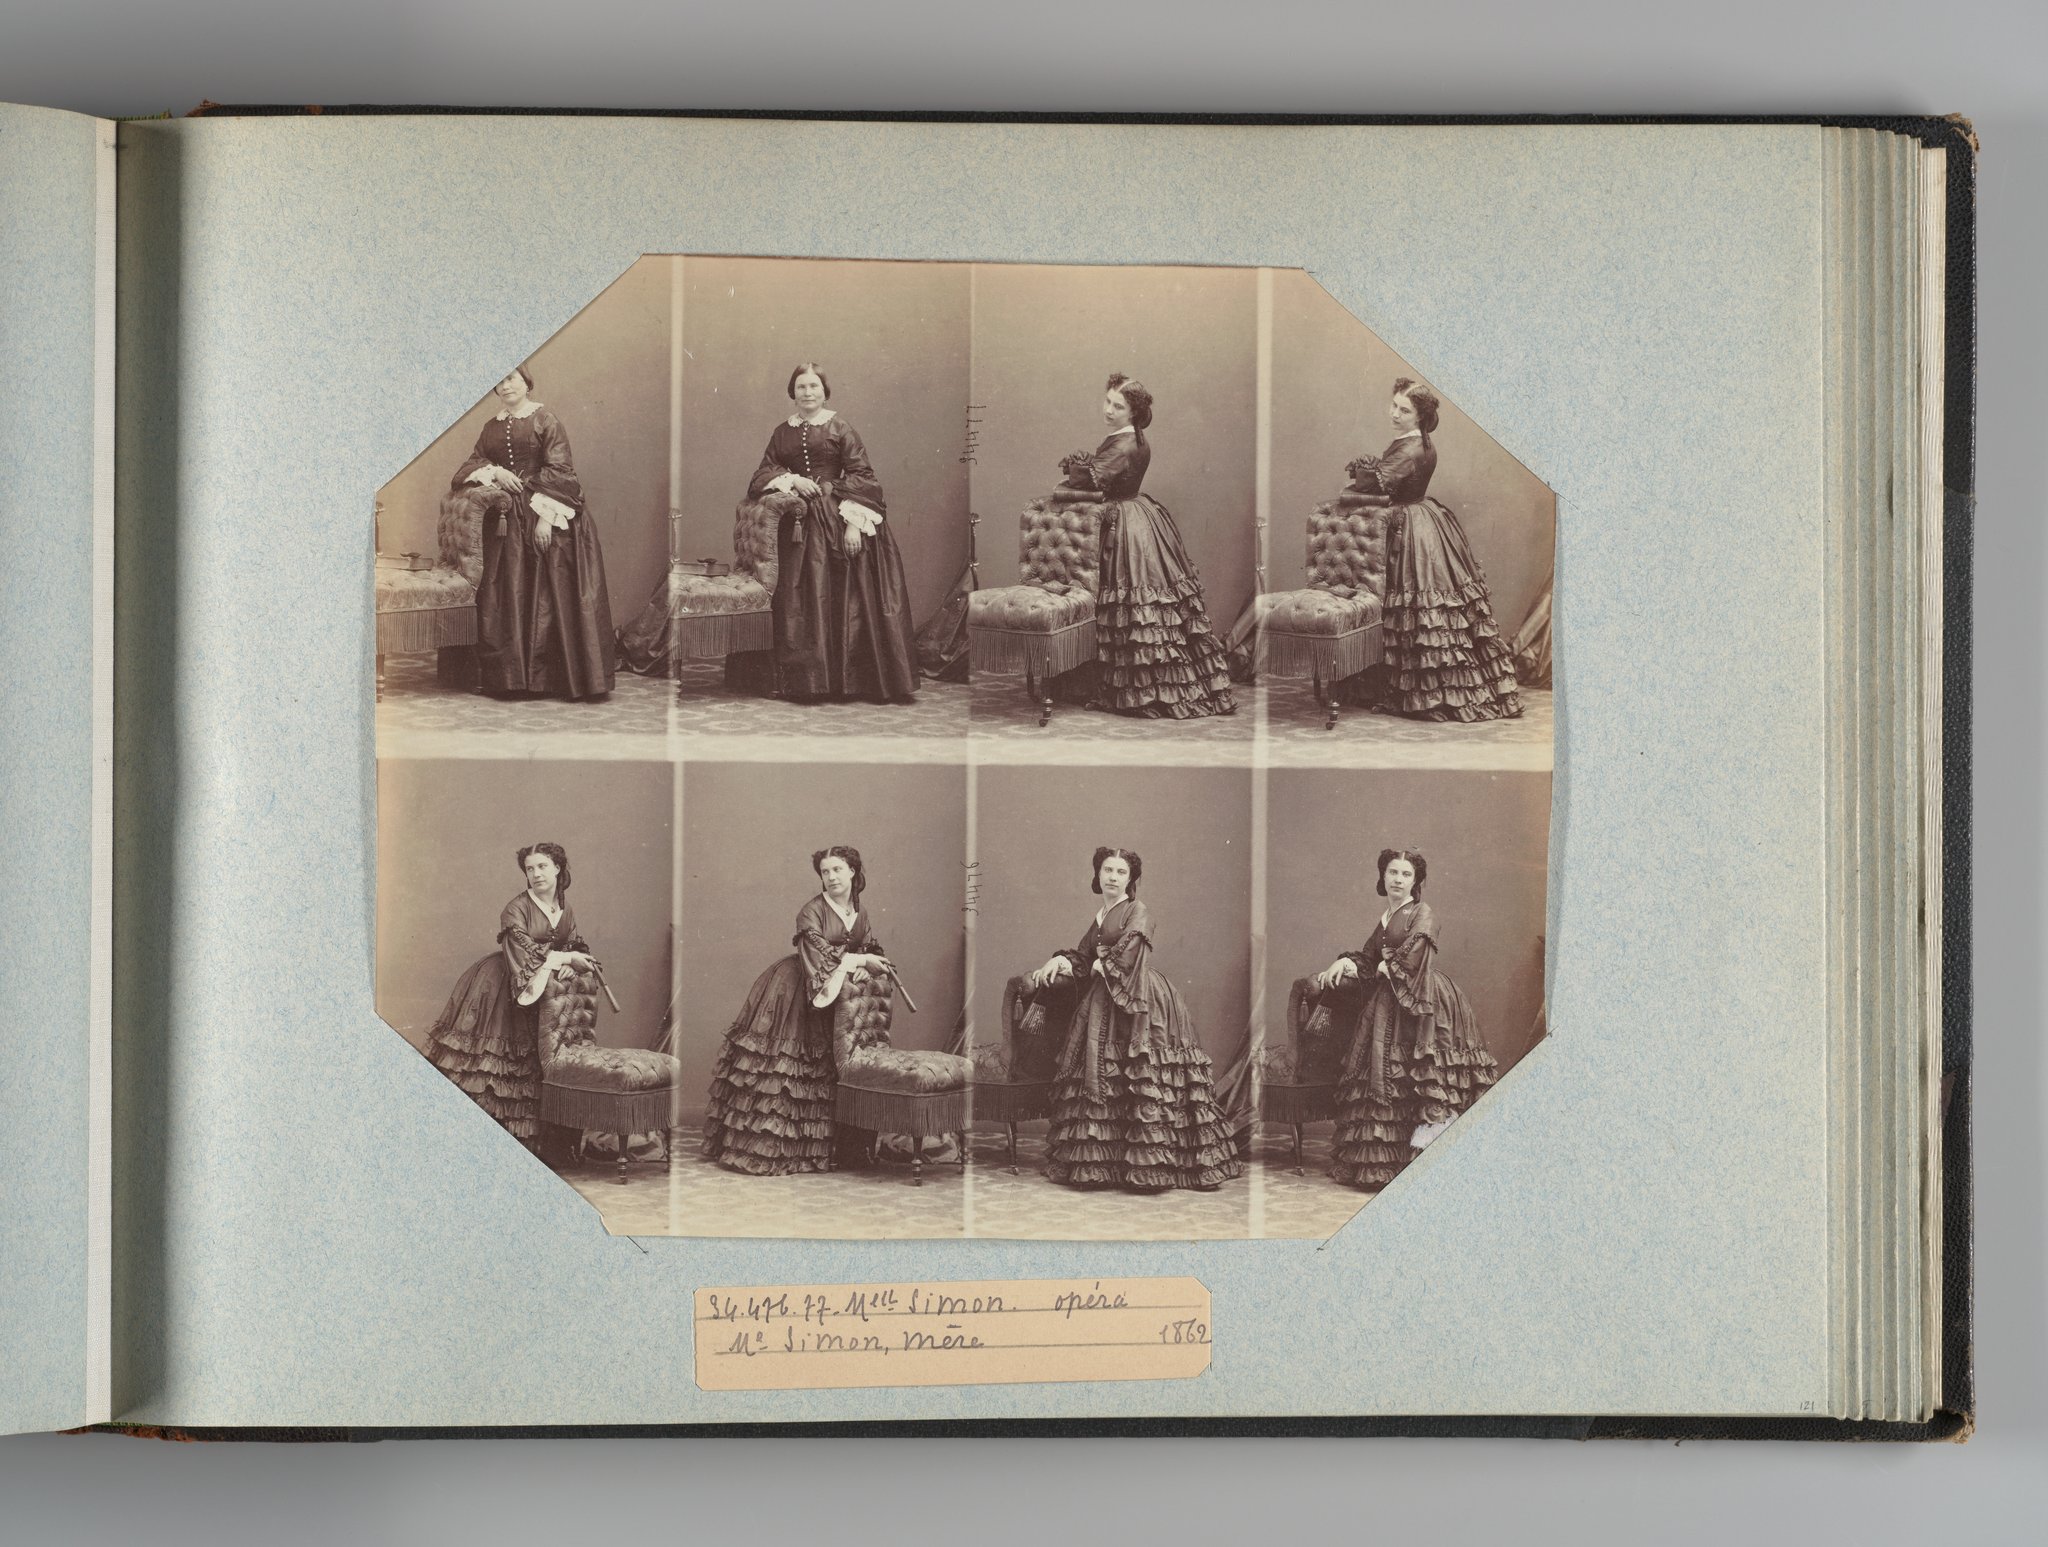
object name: photograph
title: Mlle Simon; Me Simon, mère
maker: andré-adolphe-eugène disdéri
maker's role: artist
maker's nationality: french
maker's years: 1819-1889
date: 1862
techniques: albumen silver print, glass negative